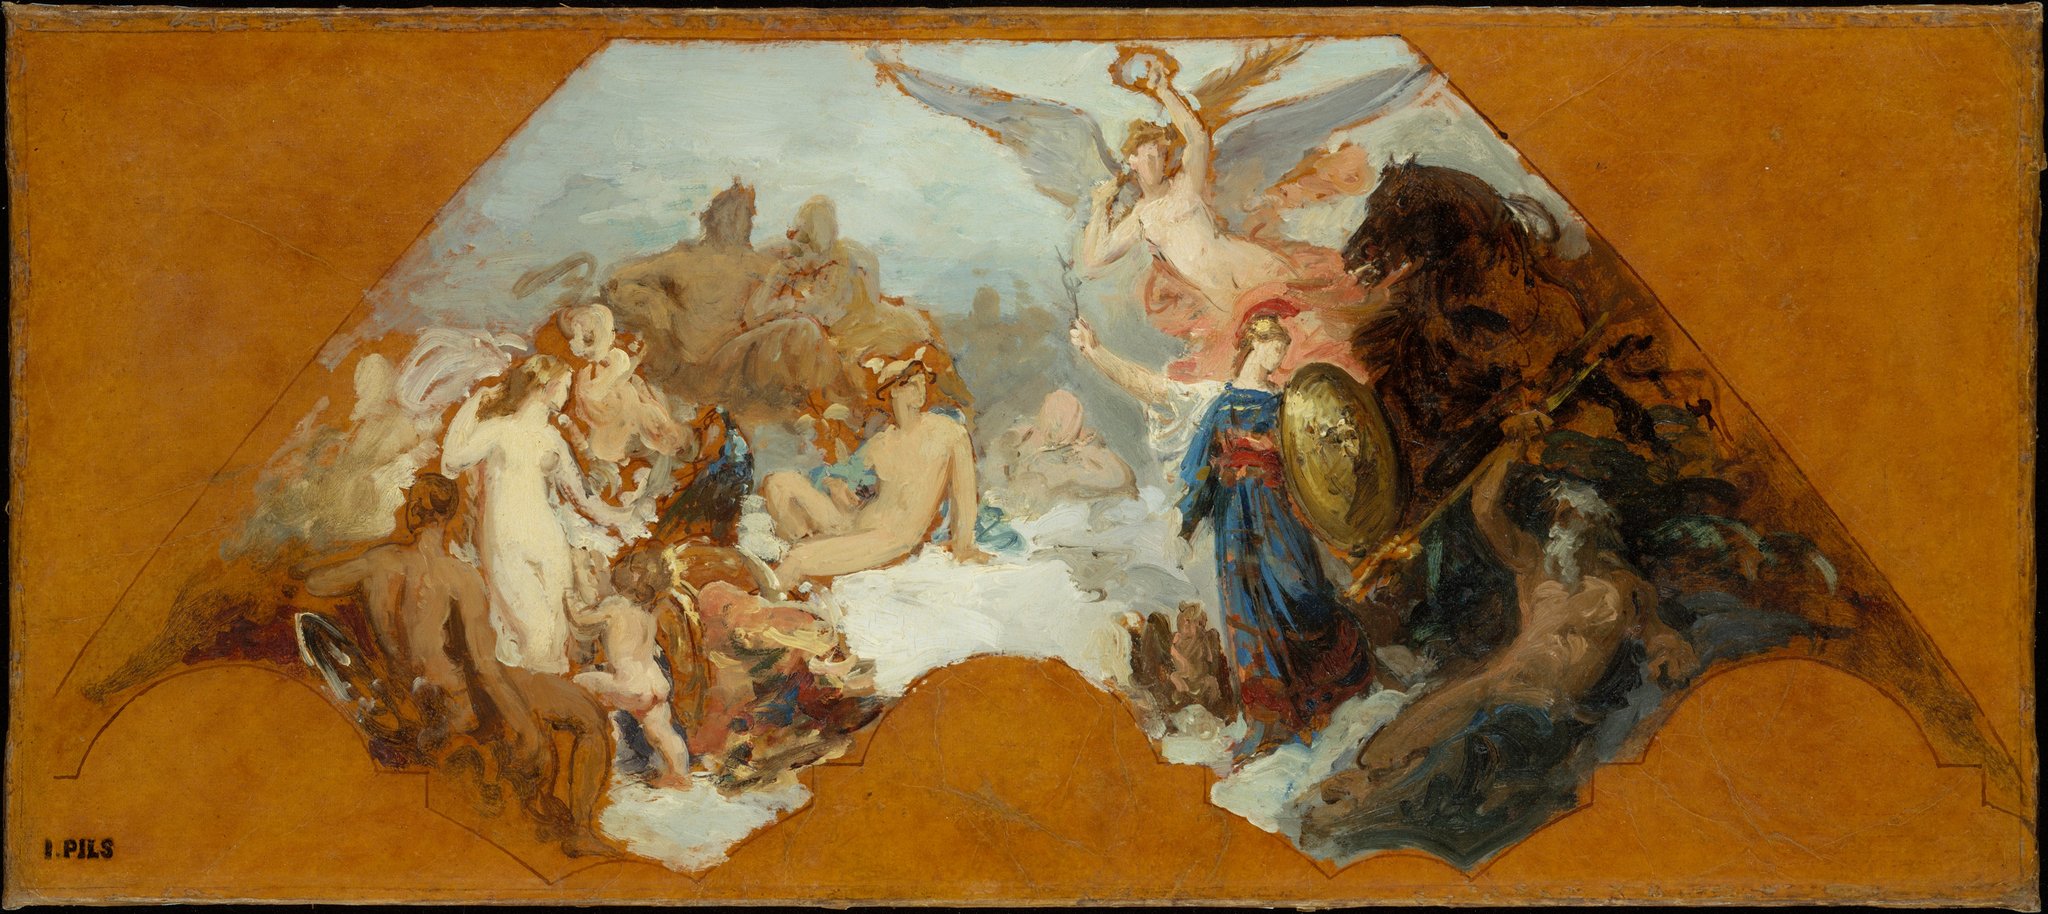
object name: drawing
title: Minerva Combating Brute Force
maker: isidore pils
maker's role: artist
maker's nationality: french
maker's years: 1813-1875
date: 1801-1900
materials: canvas, oil, paper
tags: shields,spears,minerva